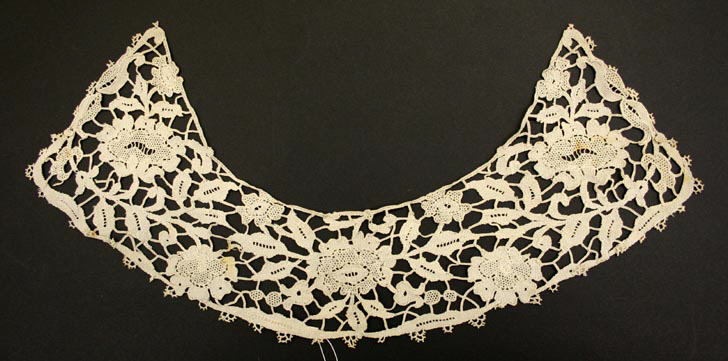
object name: collar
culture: american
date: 1700-1939